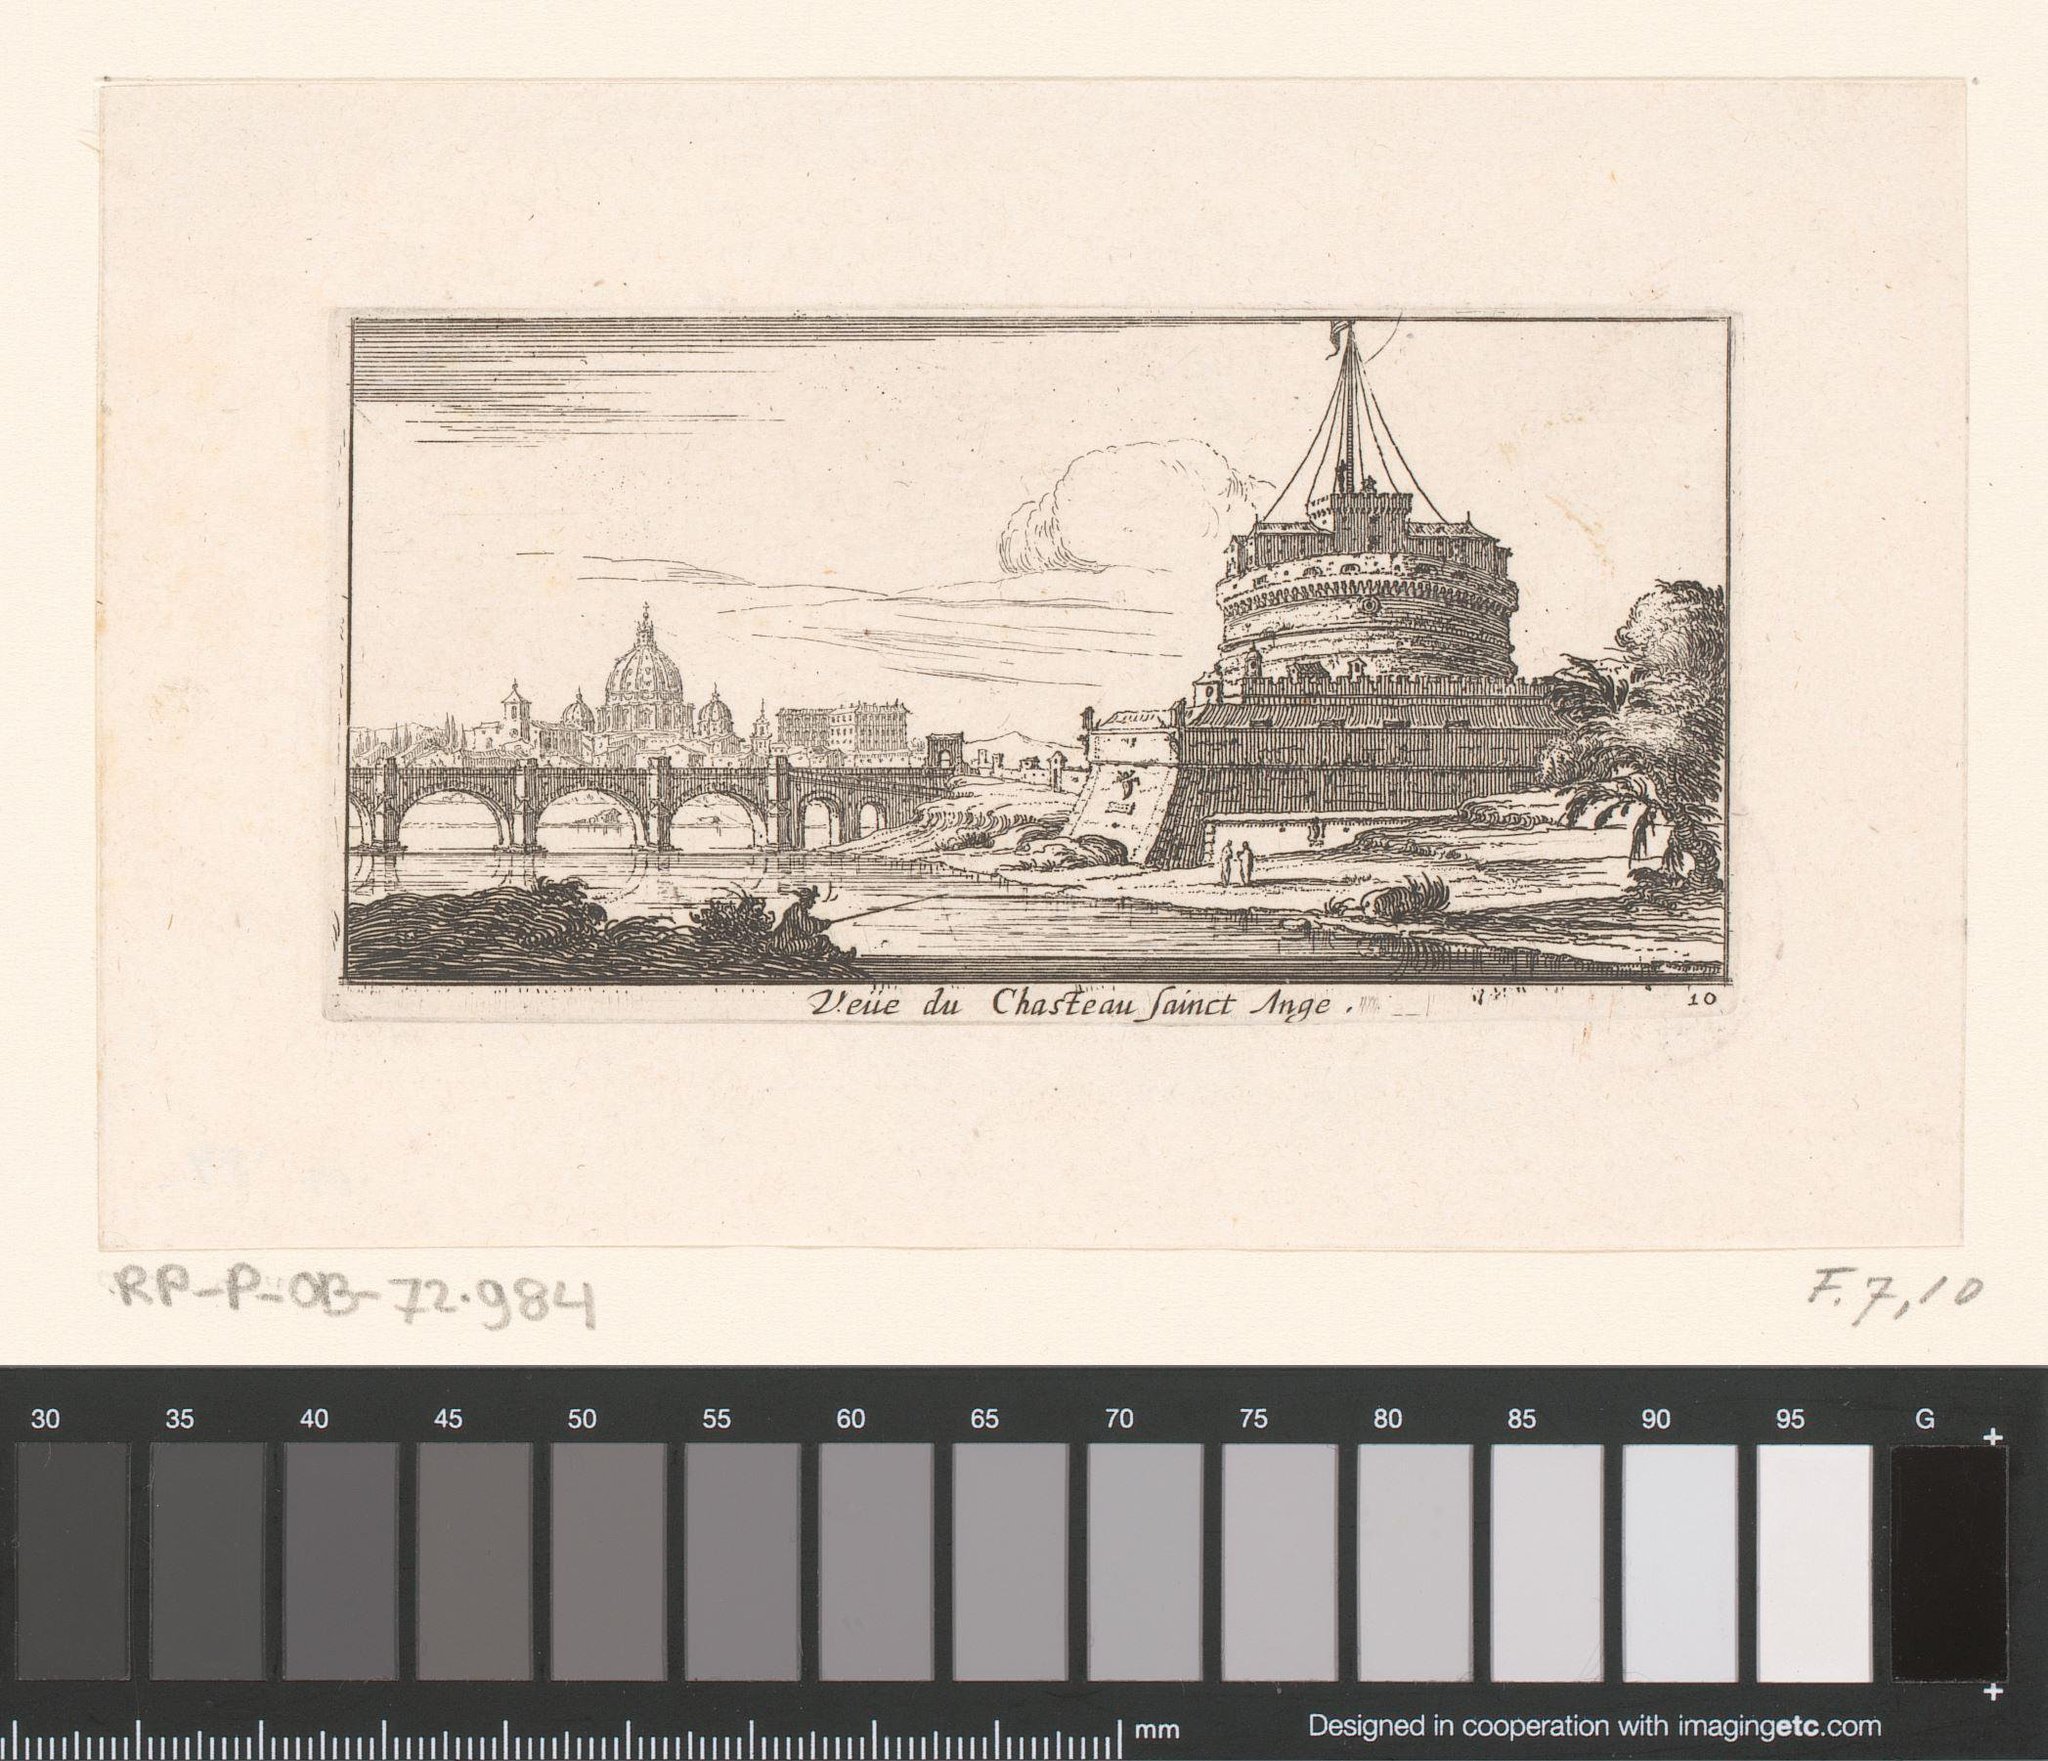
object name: print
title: Veue du Chasteau sainct Ange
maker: israël silvestre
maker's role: draughtsman, print maker, publisher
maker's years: 1621-1691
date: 1636-1661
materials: paper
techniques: etching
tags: landscape with tower or castle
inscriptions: collector's mark: Lugt 240